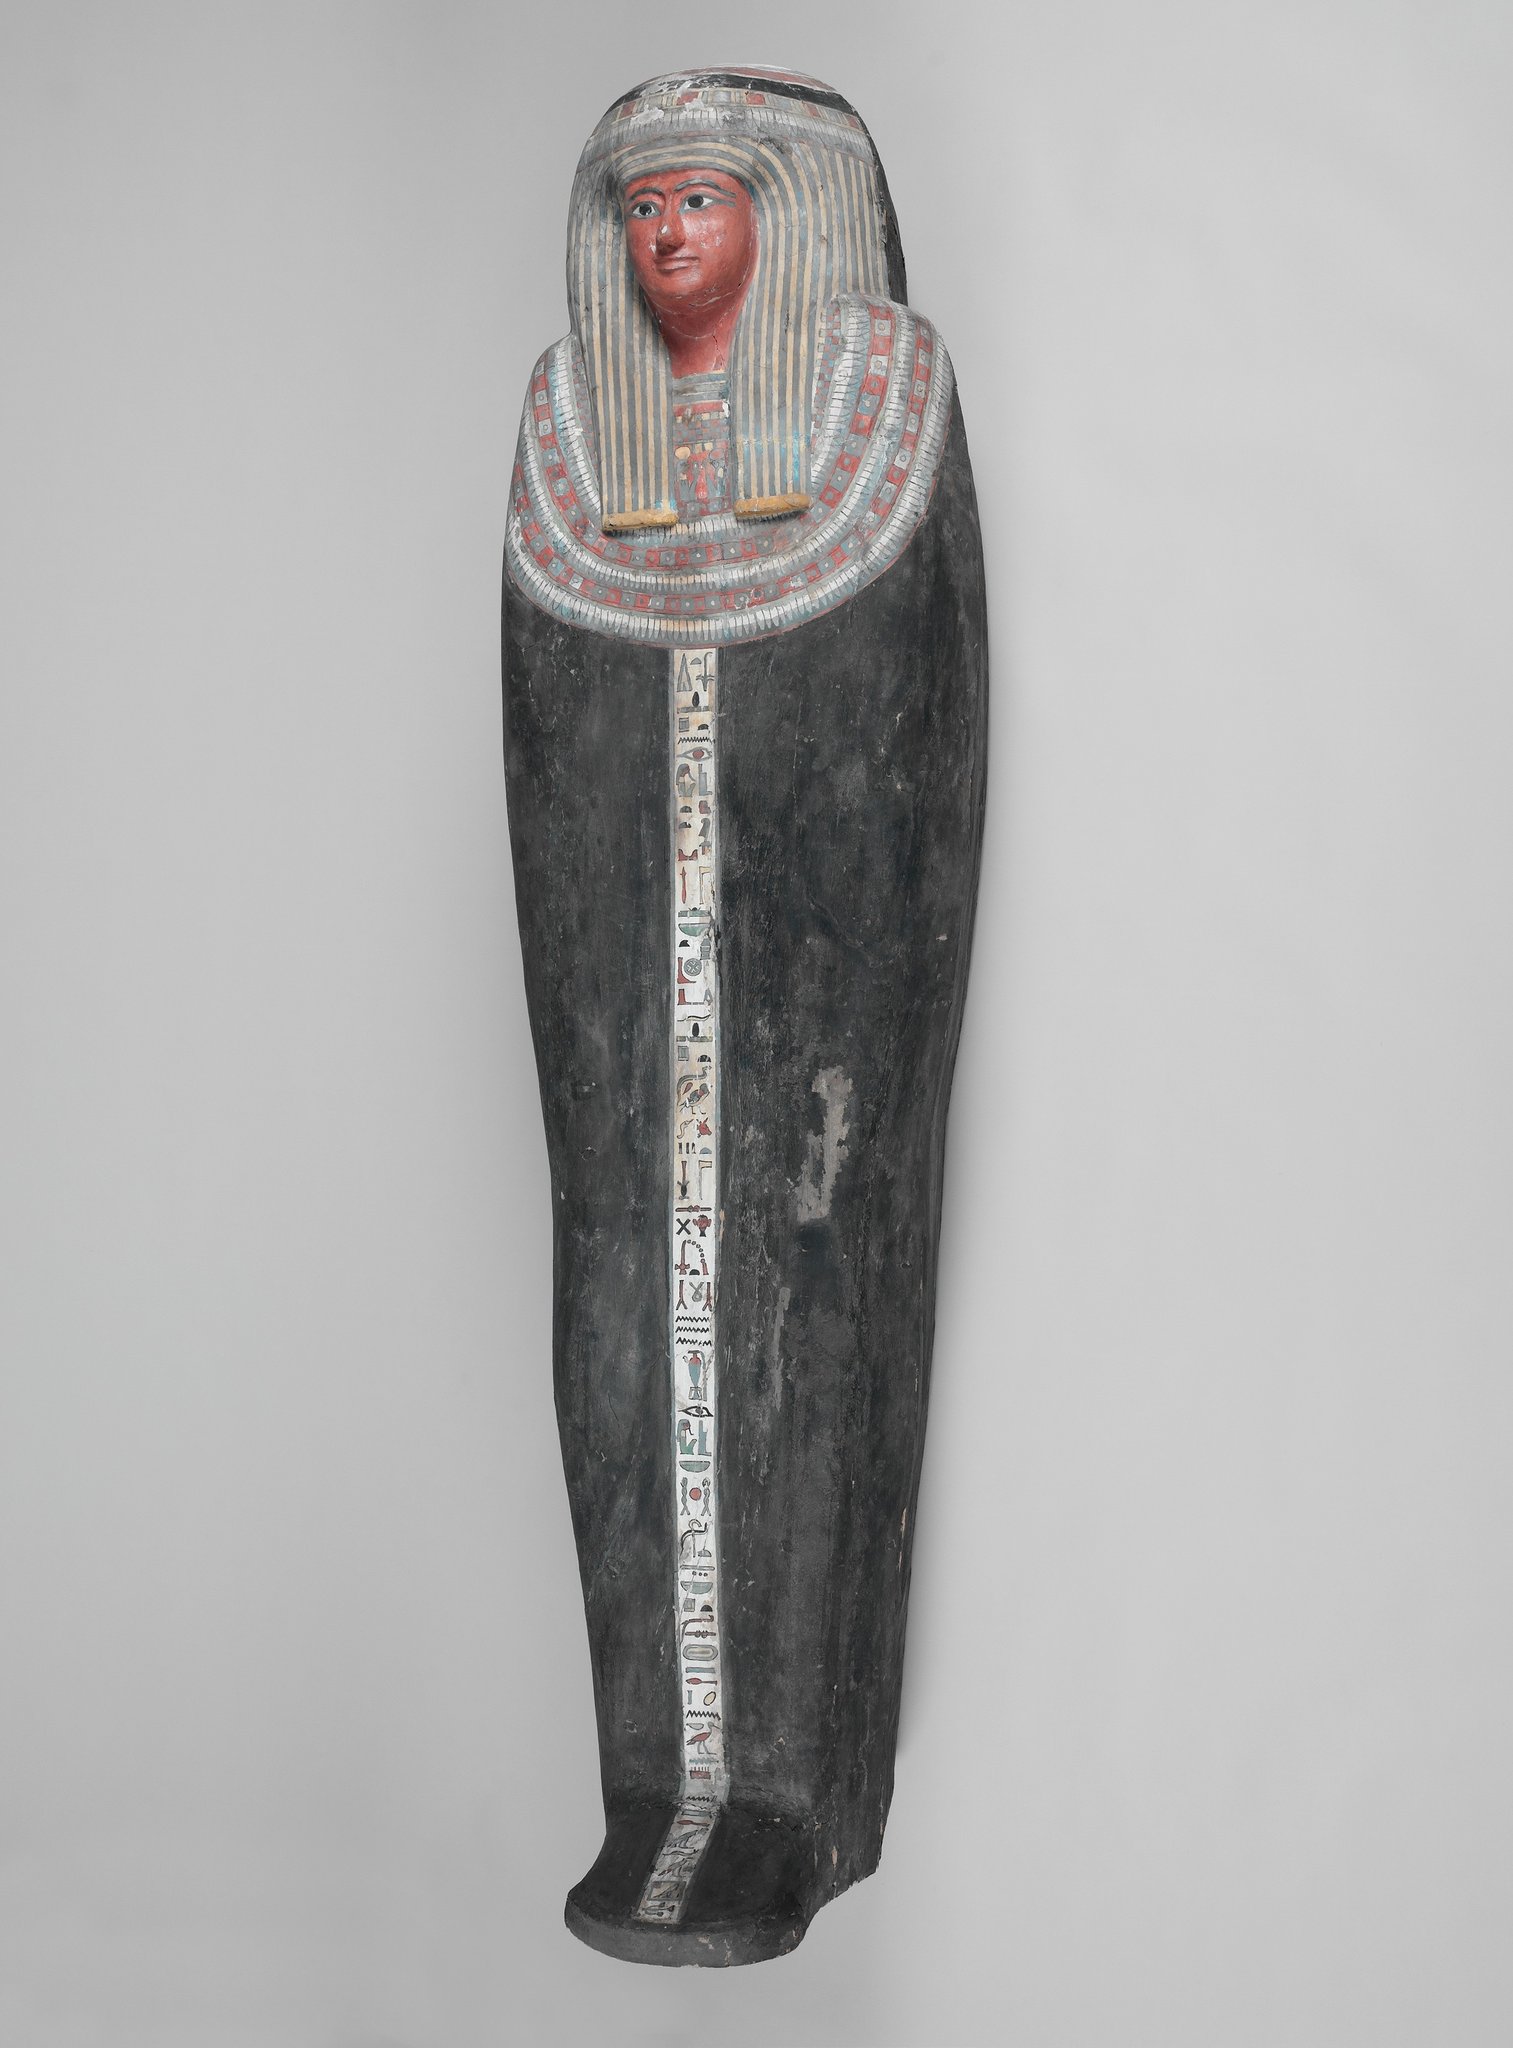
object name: coffin, nesiamun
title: Painted Wooden Coffin of Nesiamun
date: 730-664 BCE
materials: paint, wood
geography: egypt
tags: men,hieroglyphs,coffins